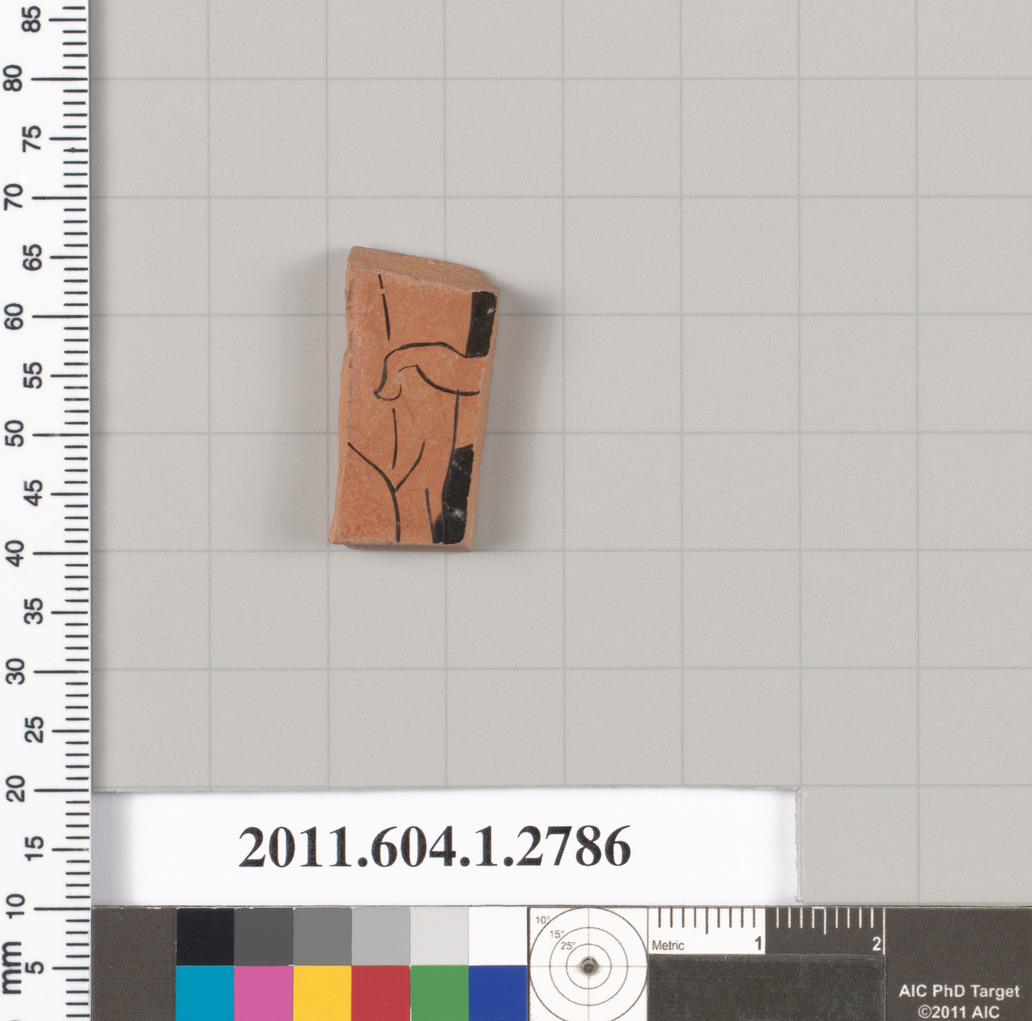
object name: kylix fragment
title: Terracotta fragment of a kylix (drinking cup)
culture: greek, attic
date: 460-450 BCE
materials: terracotta